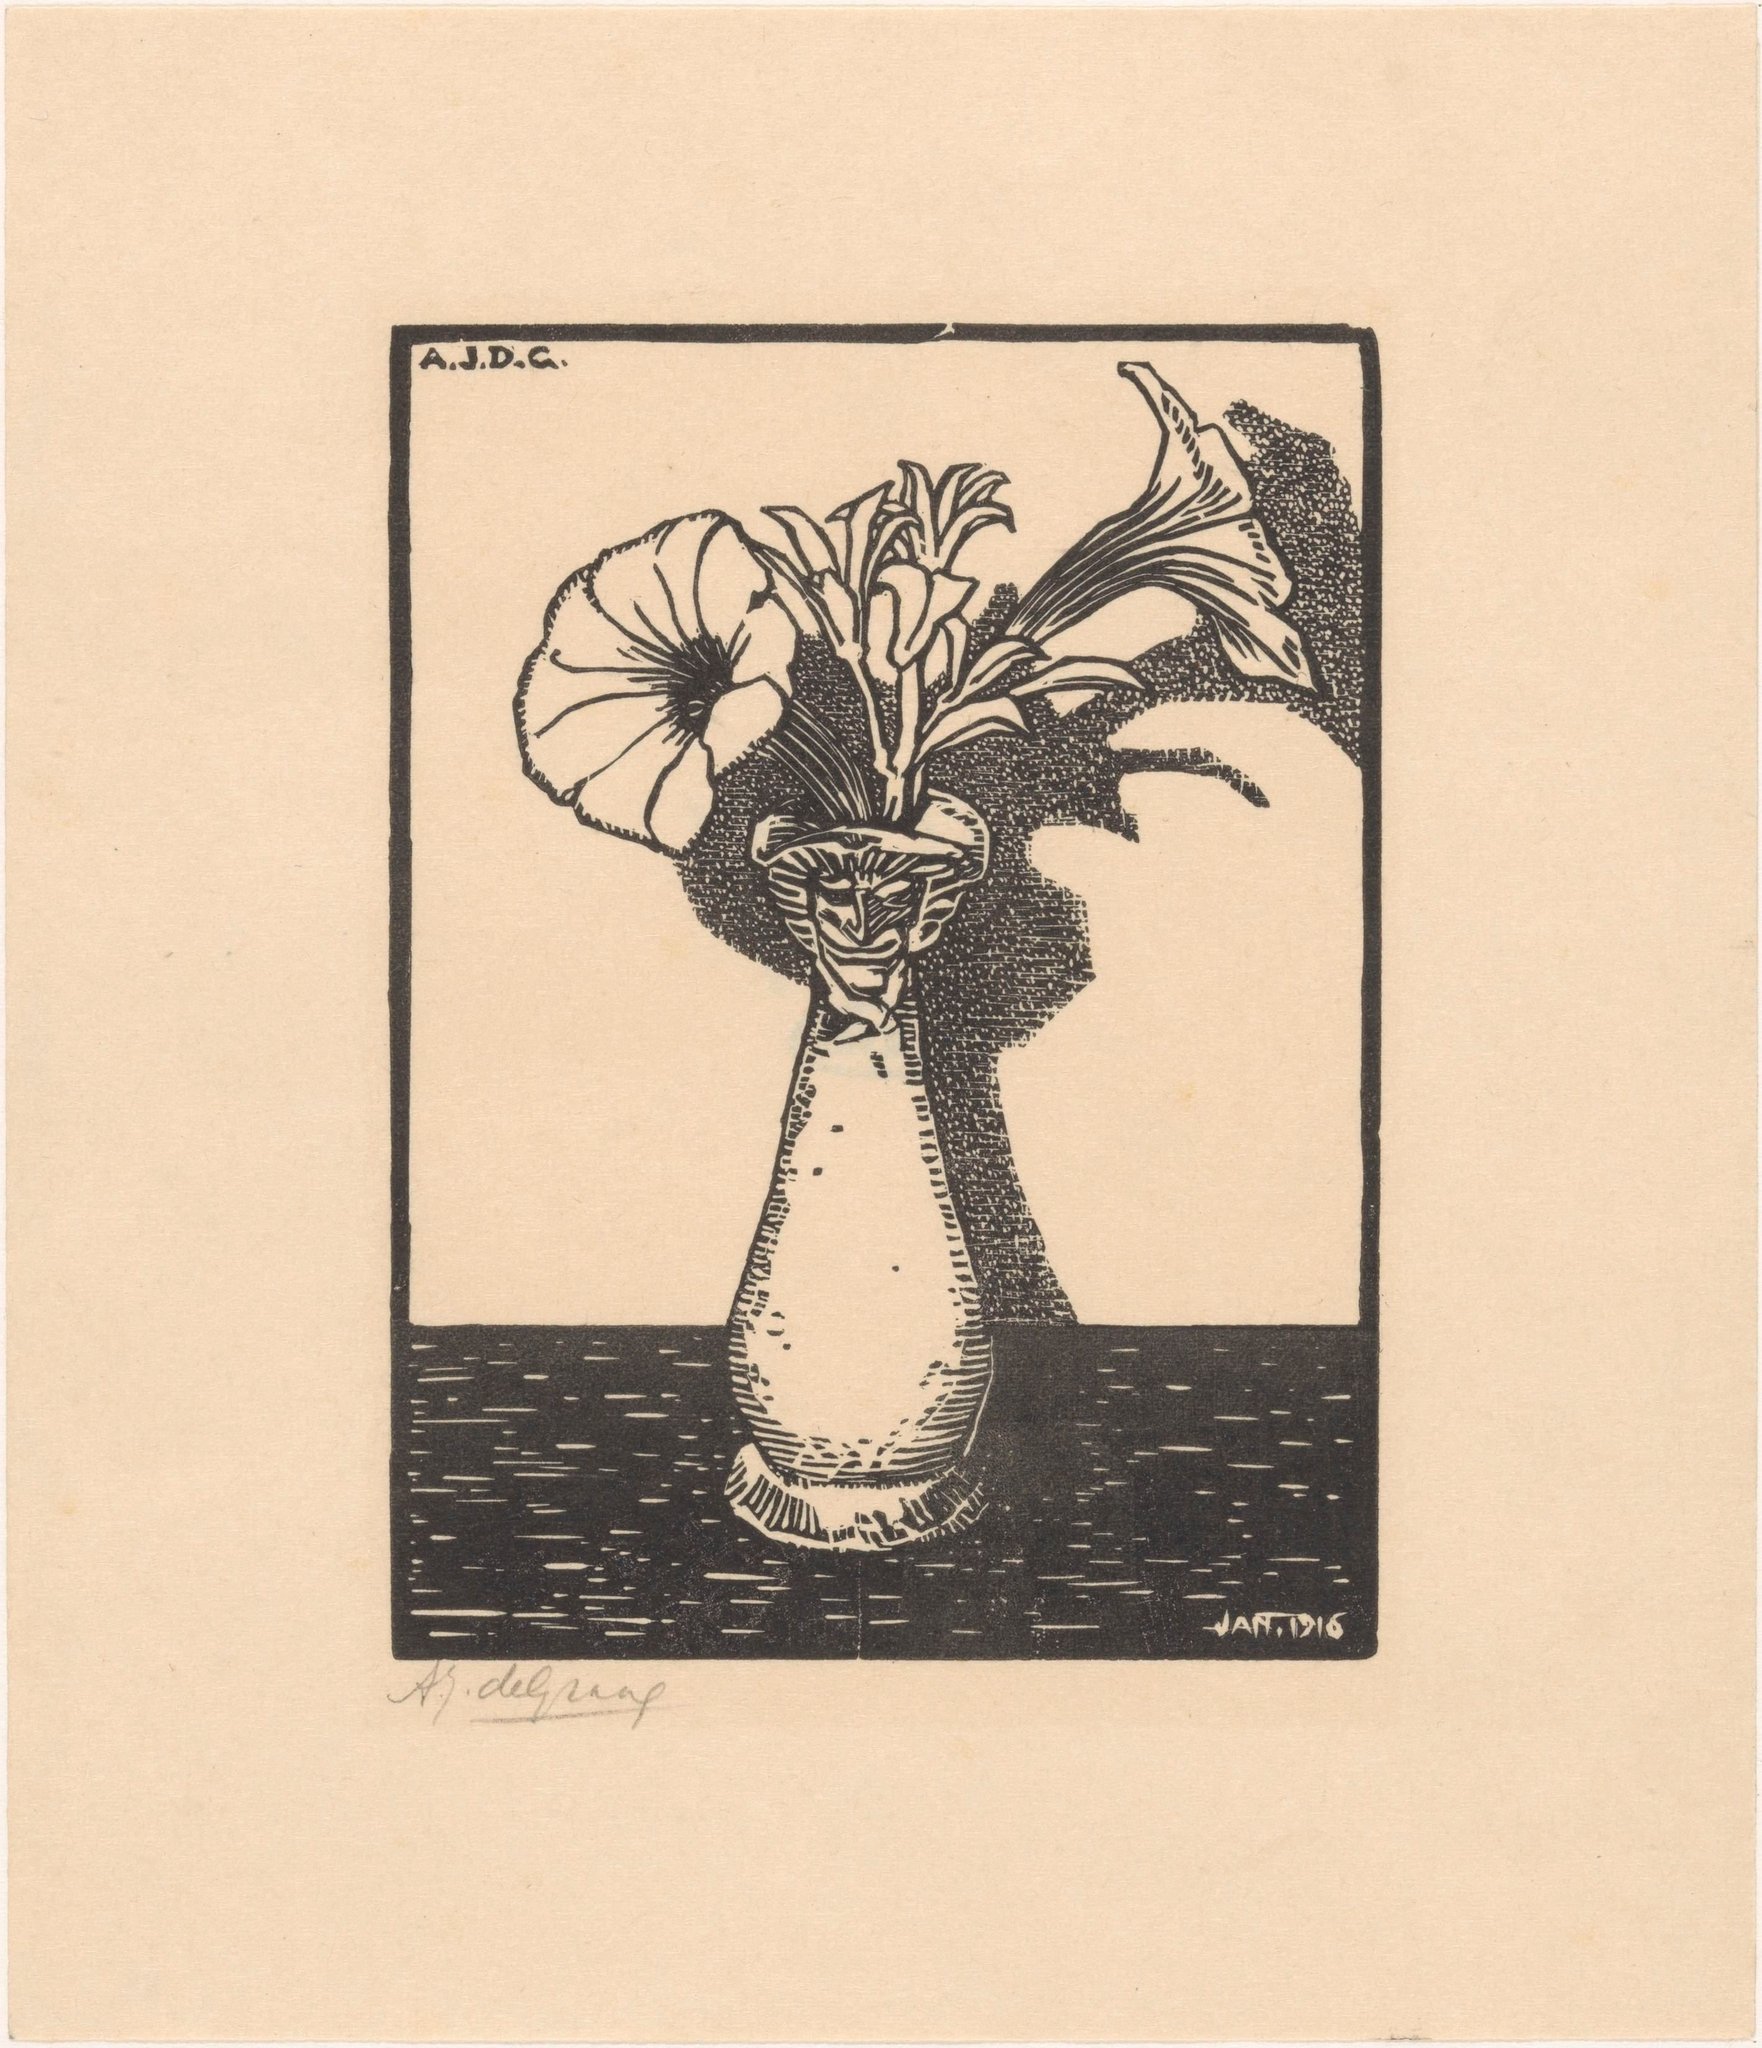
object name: print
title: Vaas met bloemen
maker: julie de graag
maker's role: draughtsman, print maker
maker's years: 1877-1924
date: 1901-1916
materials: paper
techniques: woodcut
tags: flowers in a vase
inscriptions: collector's mark: Lugt 2228